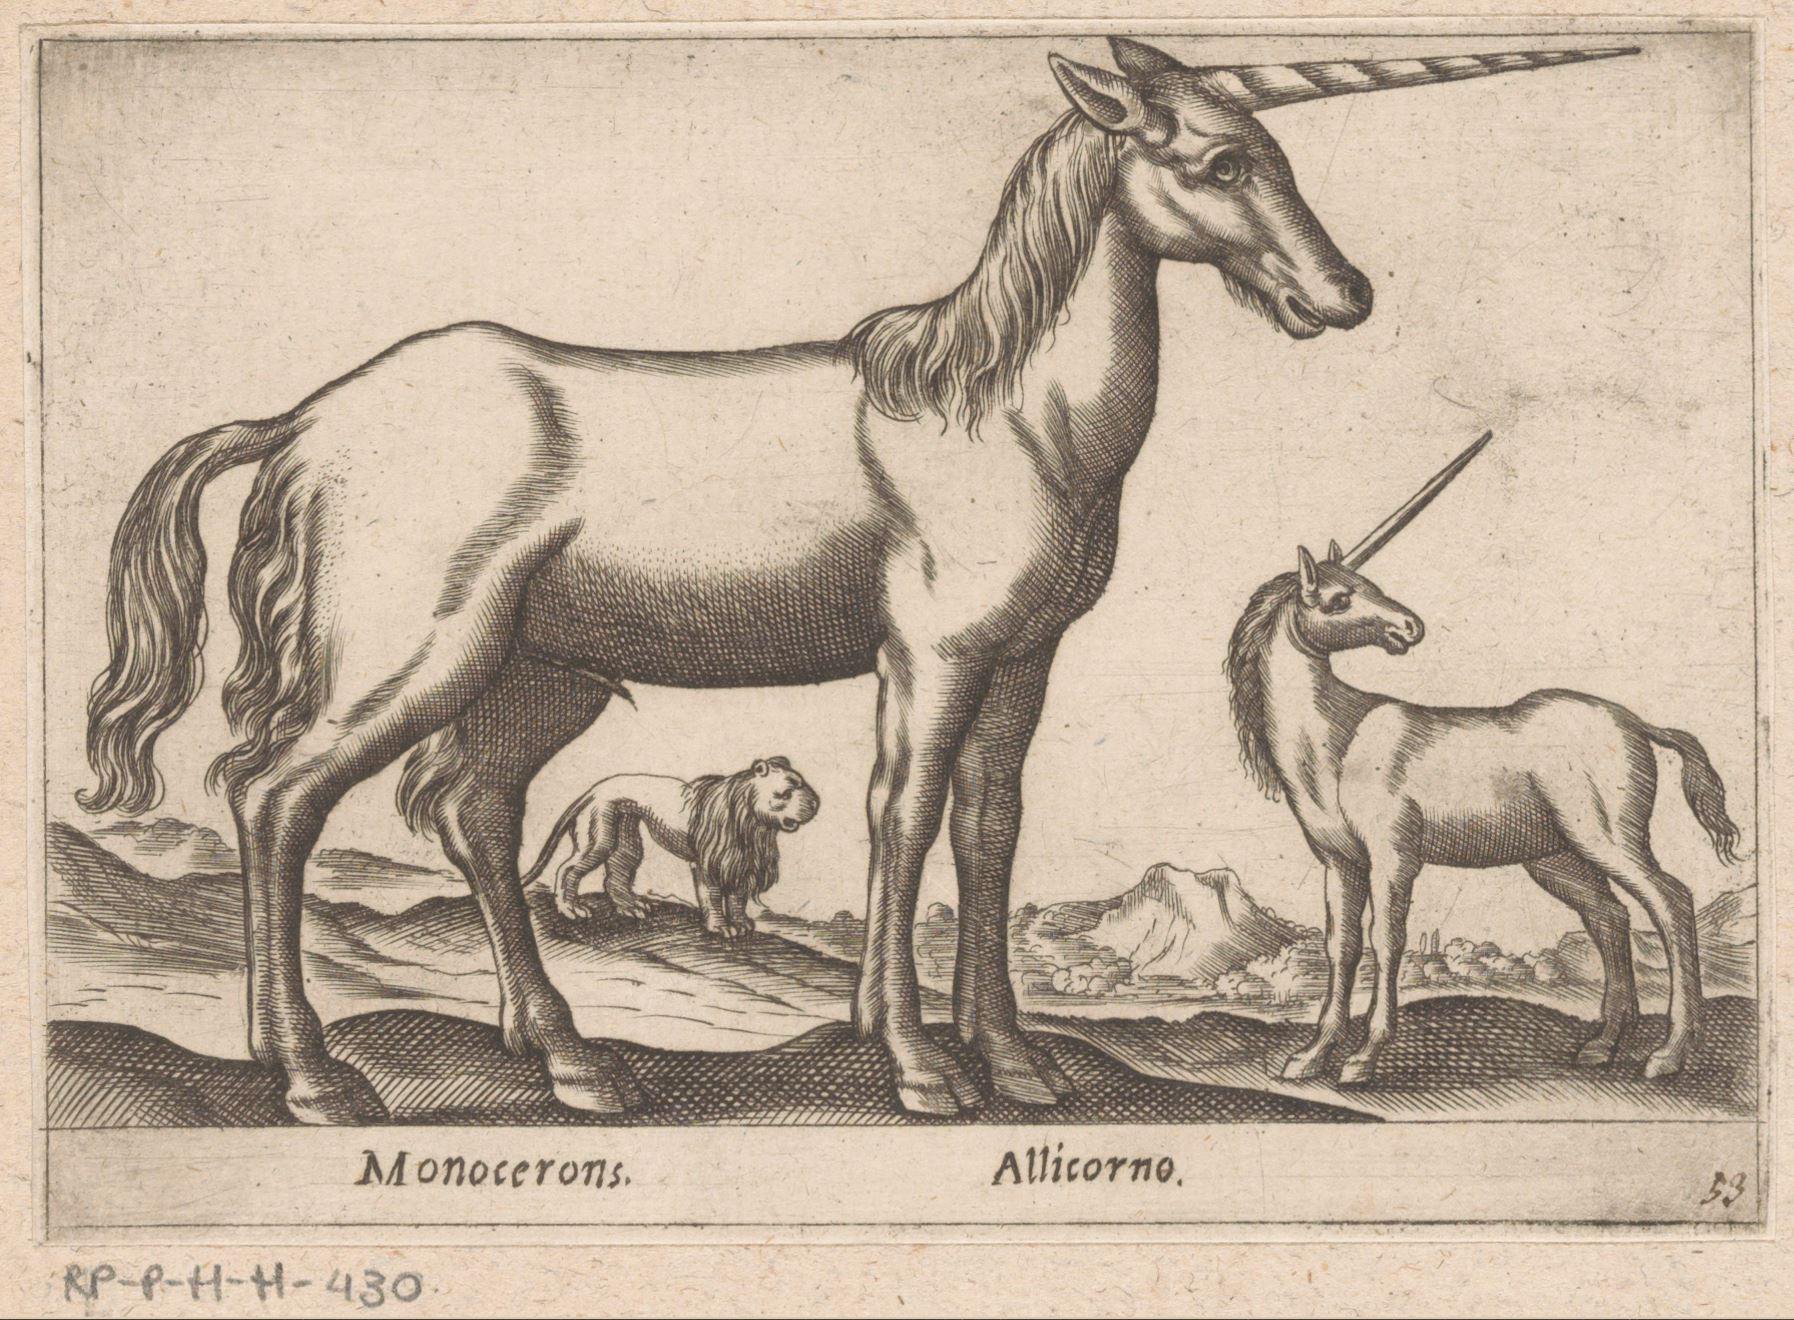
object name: print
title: Twee eenhoorns en een leeuw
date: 1565-1630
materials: paper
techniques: etching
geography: italy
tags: unicorn, beasts of prey, predatory animals: lion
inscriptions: number: ‘53’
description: Deze prent maakt deel uit van een reeks prenten van dieren door Antonio Tempesta. Bekend is dat een tweede staat (met nummering) van deze serie is uitgegeven door Giovanni Giacomo de' Rossi in 1650. Onbekend is wie de eerste staat heeft uitgegeven en wanneer.